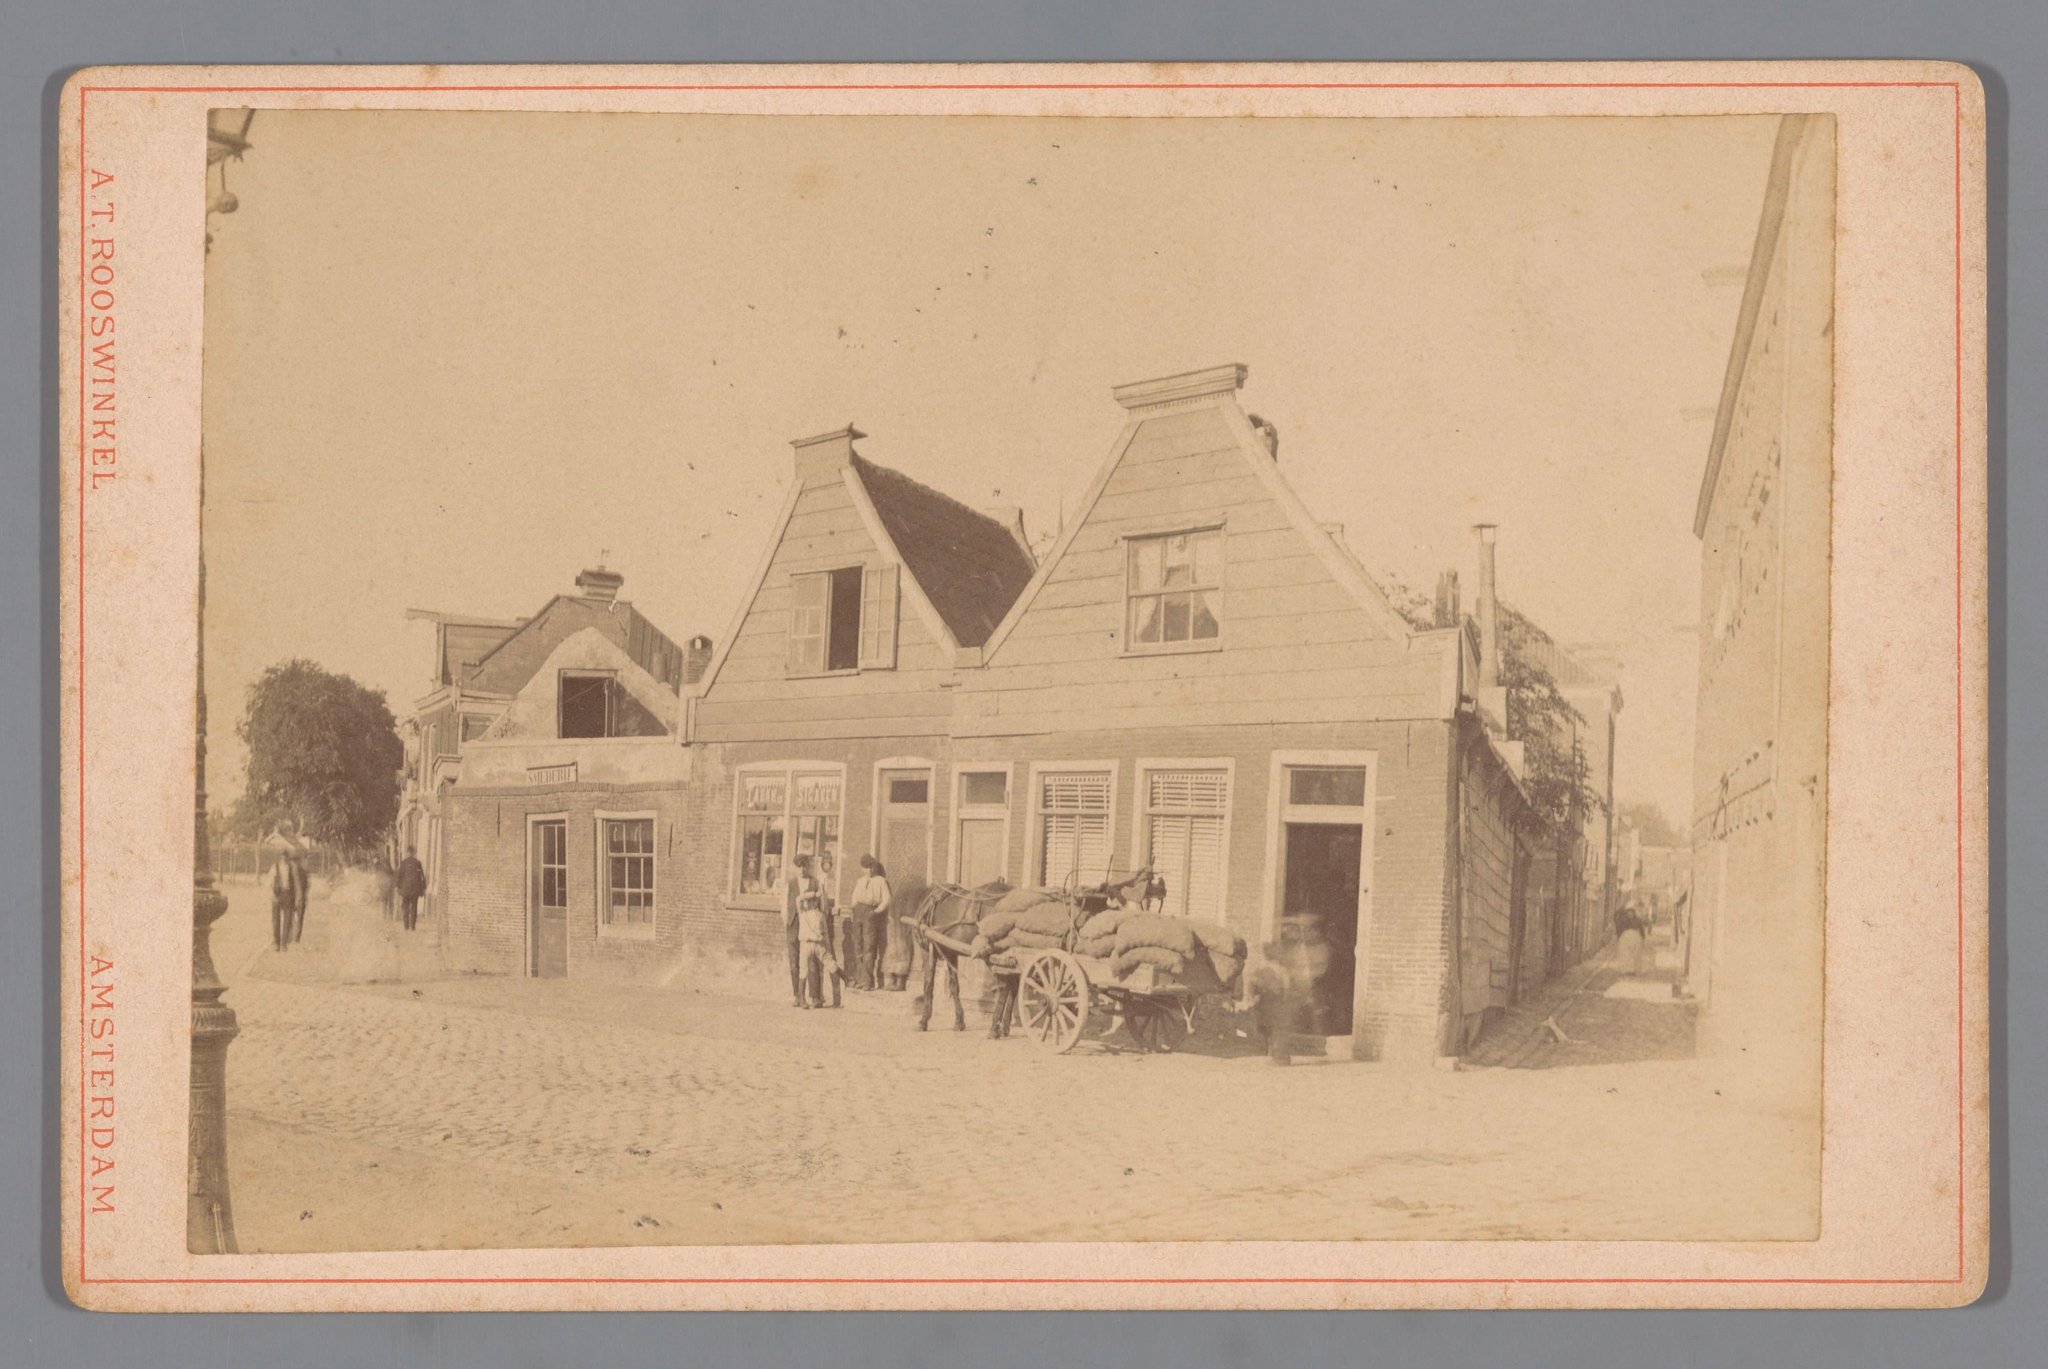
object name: cabinet photograph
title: Gezicht op de Nassaukade en het Oude Kerkpad in Amsterdam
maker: andreas theodorus rooswinkel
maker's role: fotograaf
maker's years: 1838-1909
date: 1868-1875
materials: cardboard, photographic support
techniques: albumen print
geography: amsterdam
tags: the usual house or row of houses, street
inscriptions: annotation: ‘Oude Kerkpad - (Nassau Kade)’, annotation: ‘Oude Kerkpad’, retailer's mark: ‘GEBR. DOUWES./ ATELIER/ Grimburgwal 15/ AMSTERDAM.’